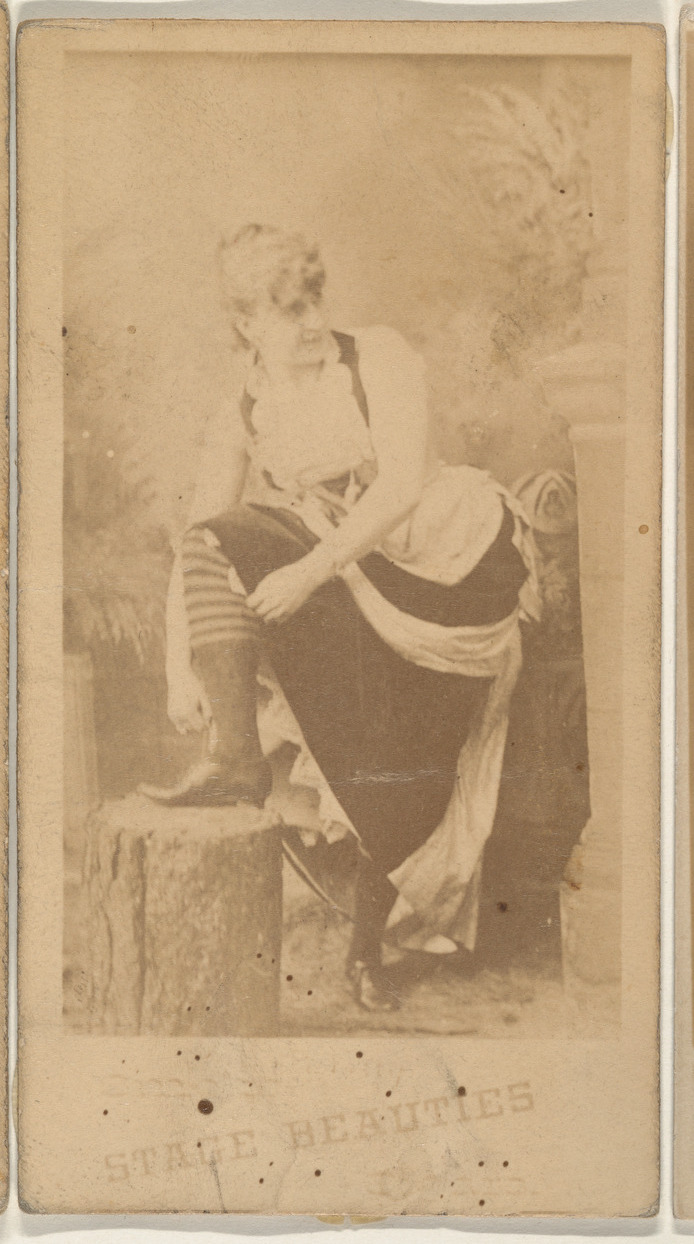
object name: photograph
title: Actress wearing costume with striped tights, from the Actresses series (N666) to promote Stage Beauties Cigars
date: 1888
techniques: albumen silver print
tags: portraits,women,actresses